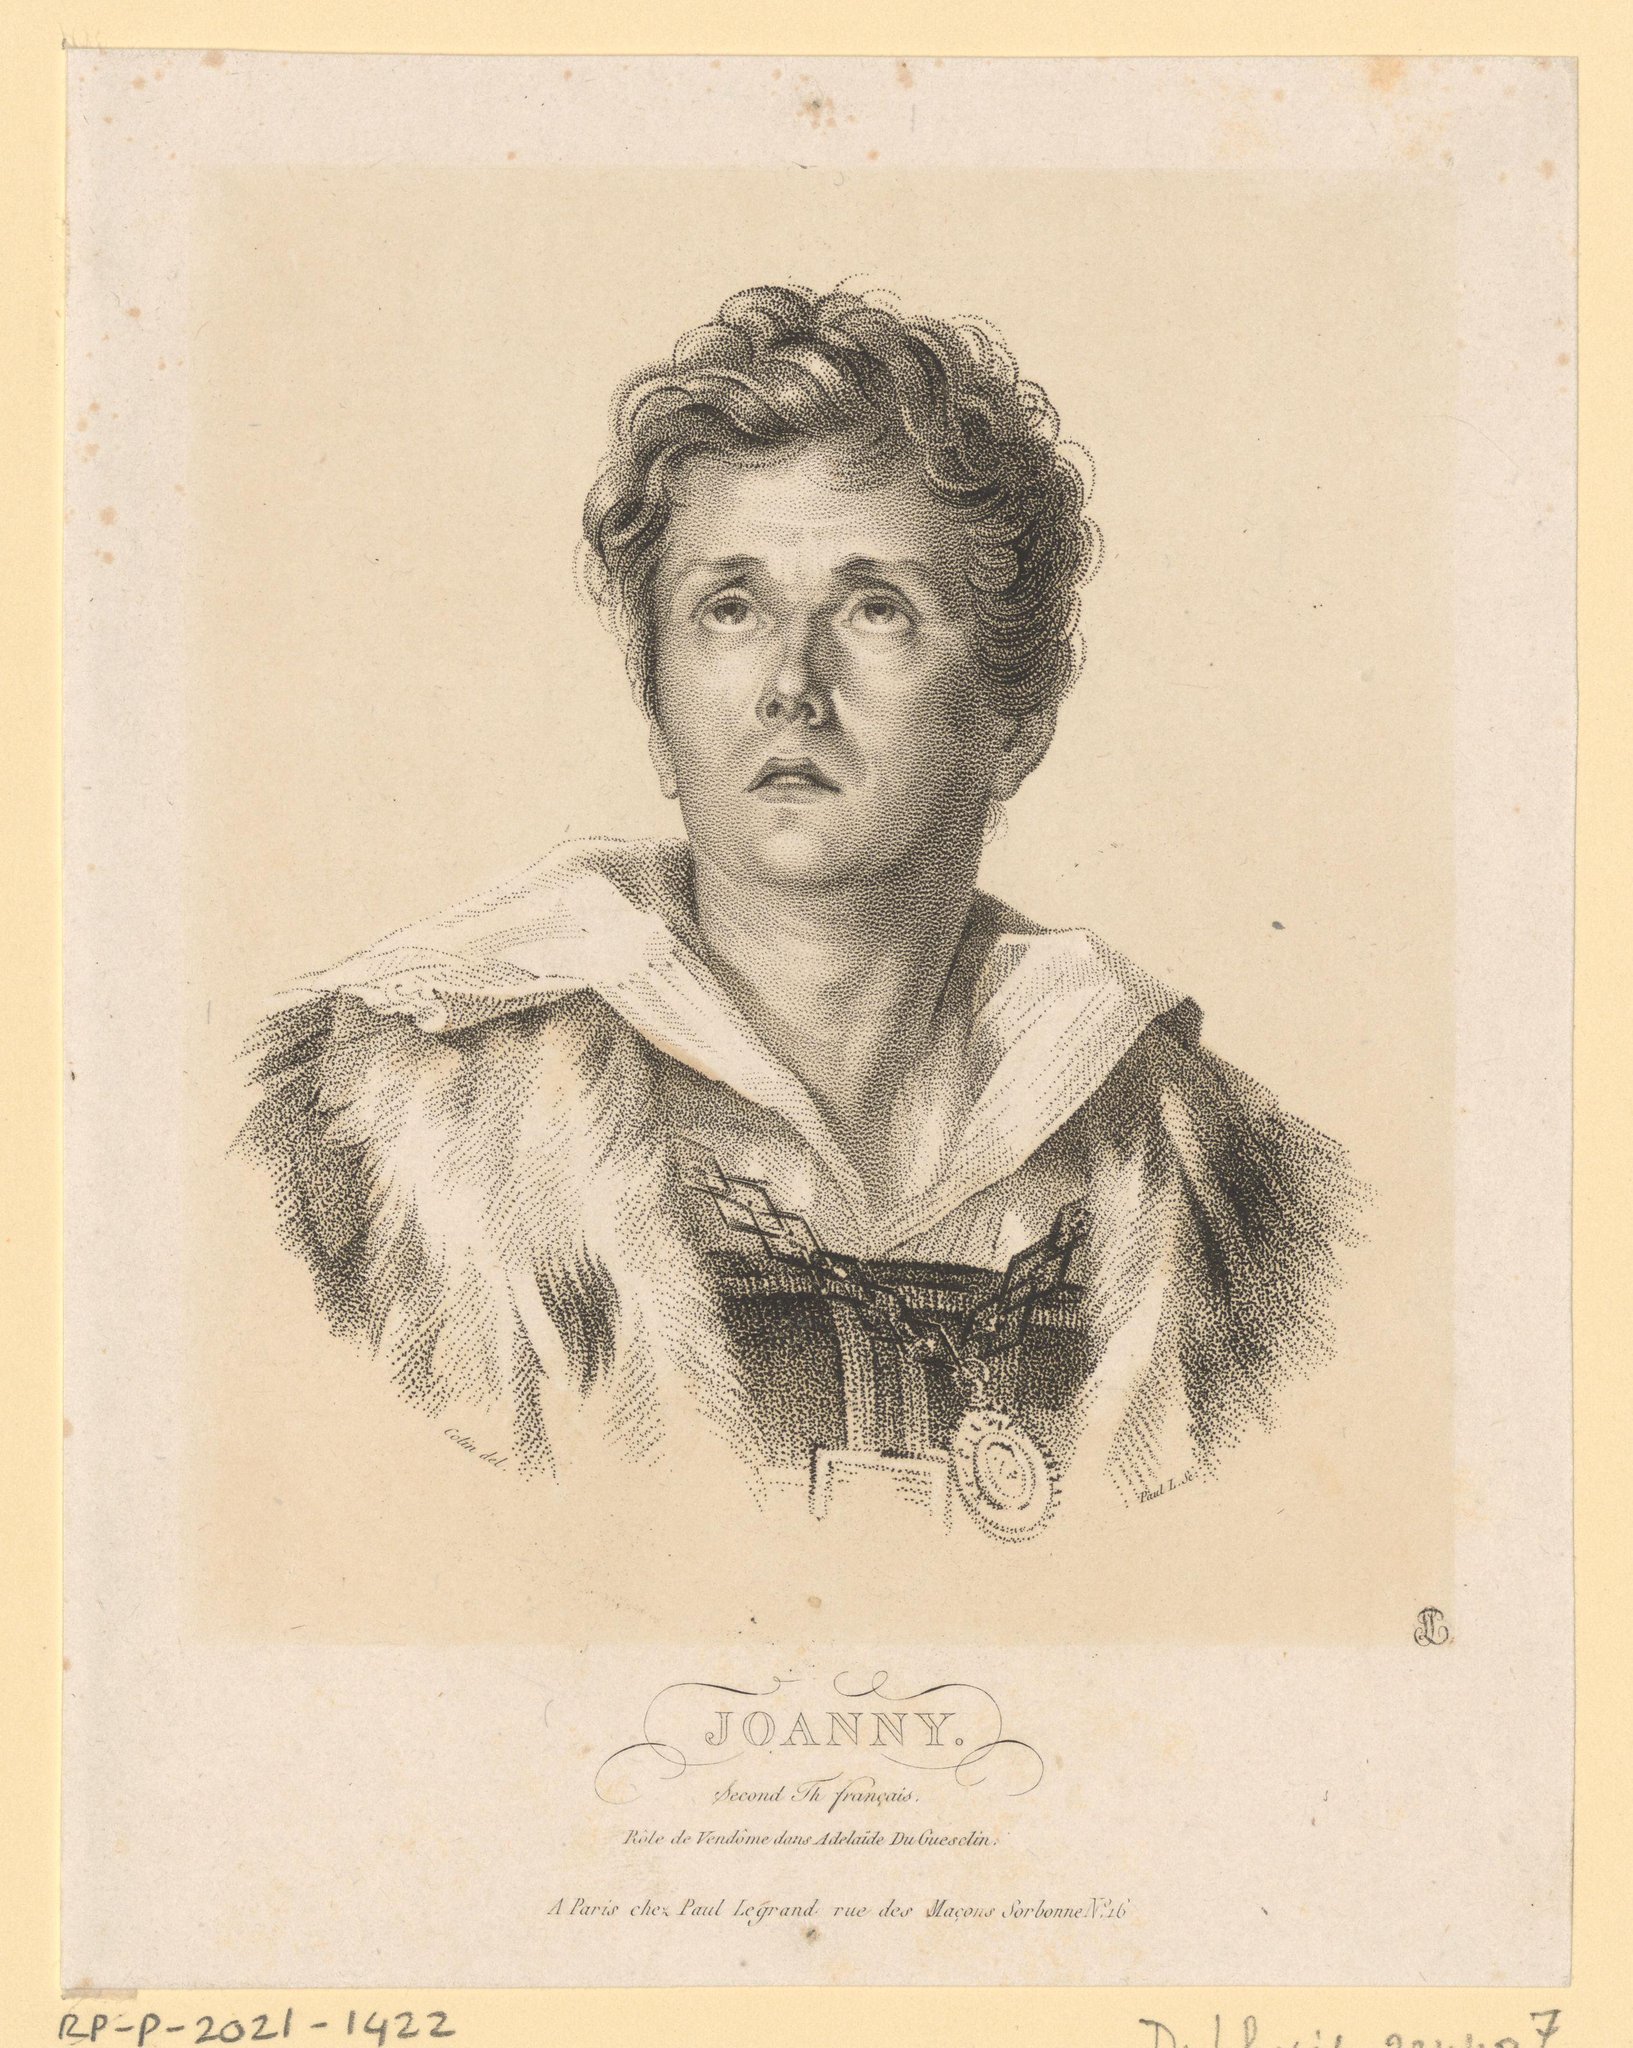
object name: print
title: Portret van Joanny als hertog van Vendôme in het toneelstuk Adélaïde du Guesclin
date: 1814-1848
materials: paper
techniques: stippling, tone lithography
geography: paris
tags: historical persons, portrait of actor, actress